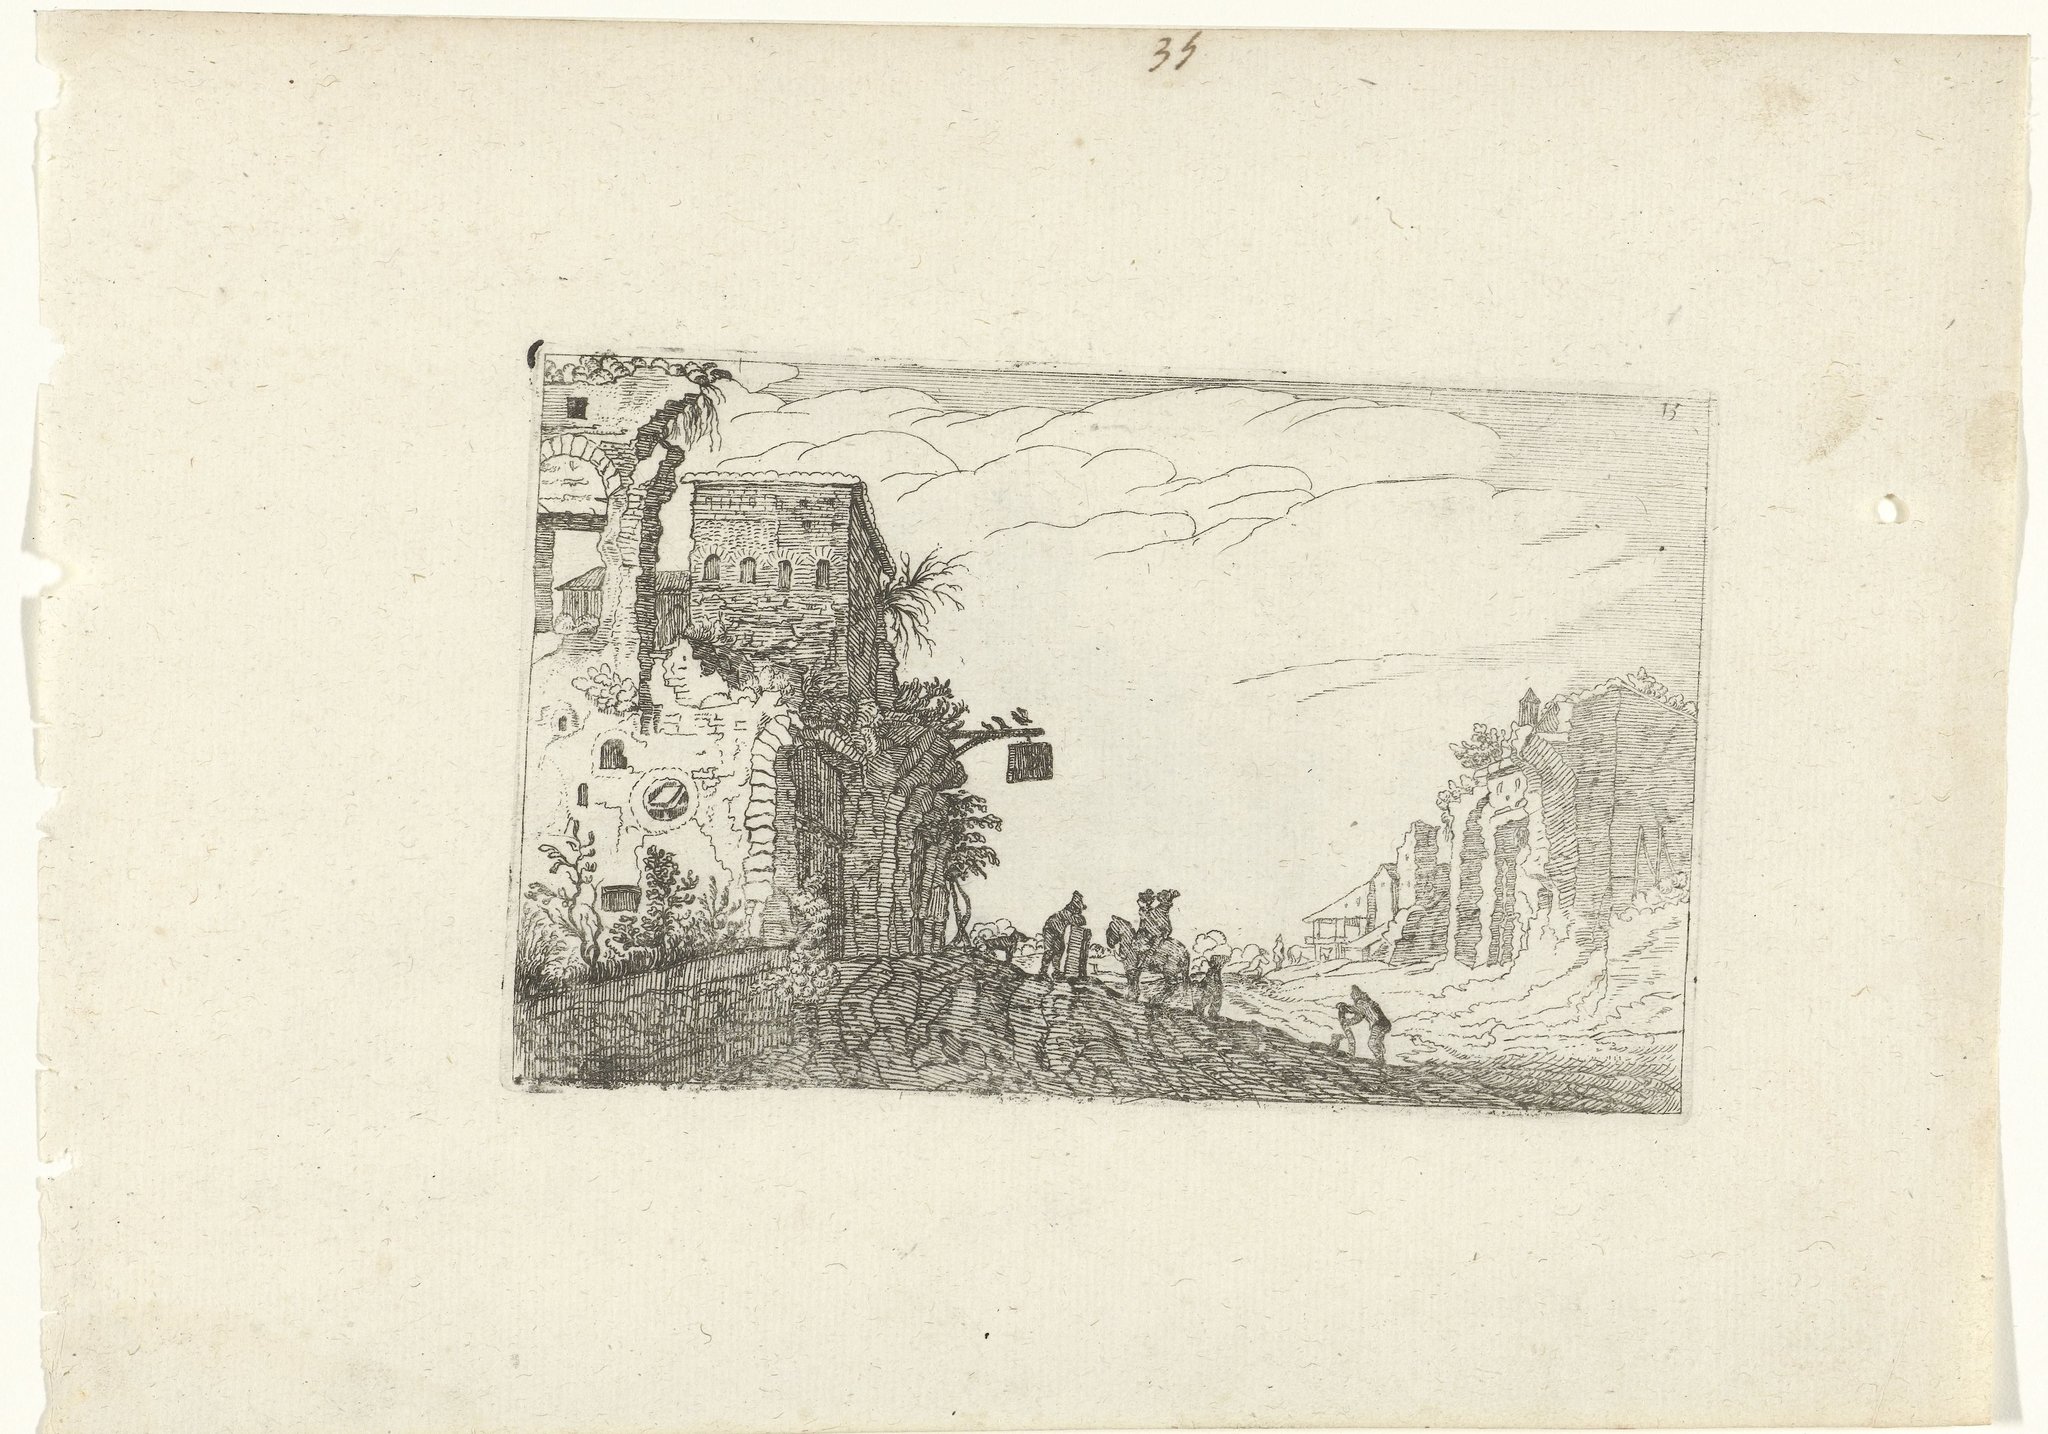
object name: print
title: Weg tussen ruïnes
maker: Anonymous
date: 1594-1685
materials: paper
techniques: etching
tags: landscape with ruins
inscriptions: collector's mark: Lugt 2760, inscription: ‘35’, collector's mark: Lugt 2228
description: Een weg met ruïnes aan weerszijden. Links hangt aan de muur een uithangbord. Daarvoor de silhoueten van reizigers, waarvan één te paard. Prent maakt deel uit van een serie Romeinse ruïnes en kustlandschappen naar prenten van Willem van Nieulandt. Deze serie is een kopie van de serie, die Claes Jansz Visscher naar Van Nieulandt maakte.